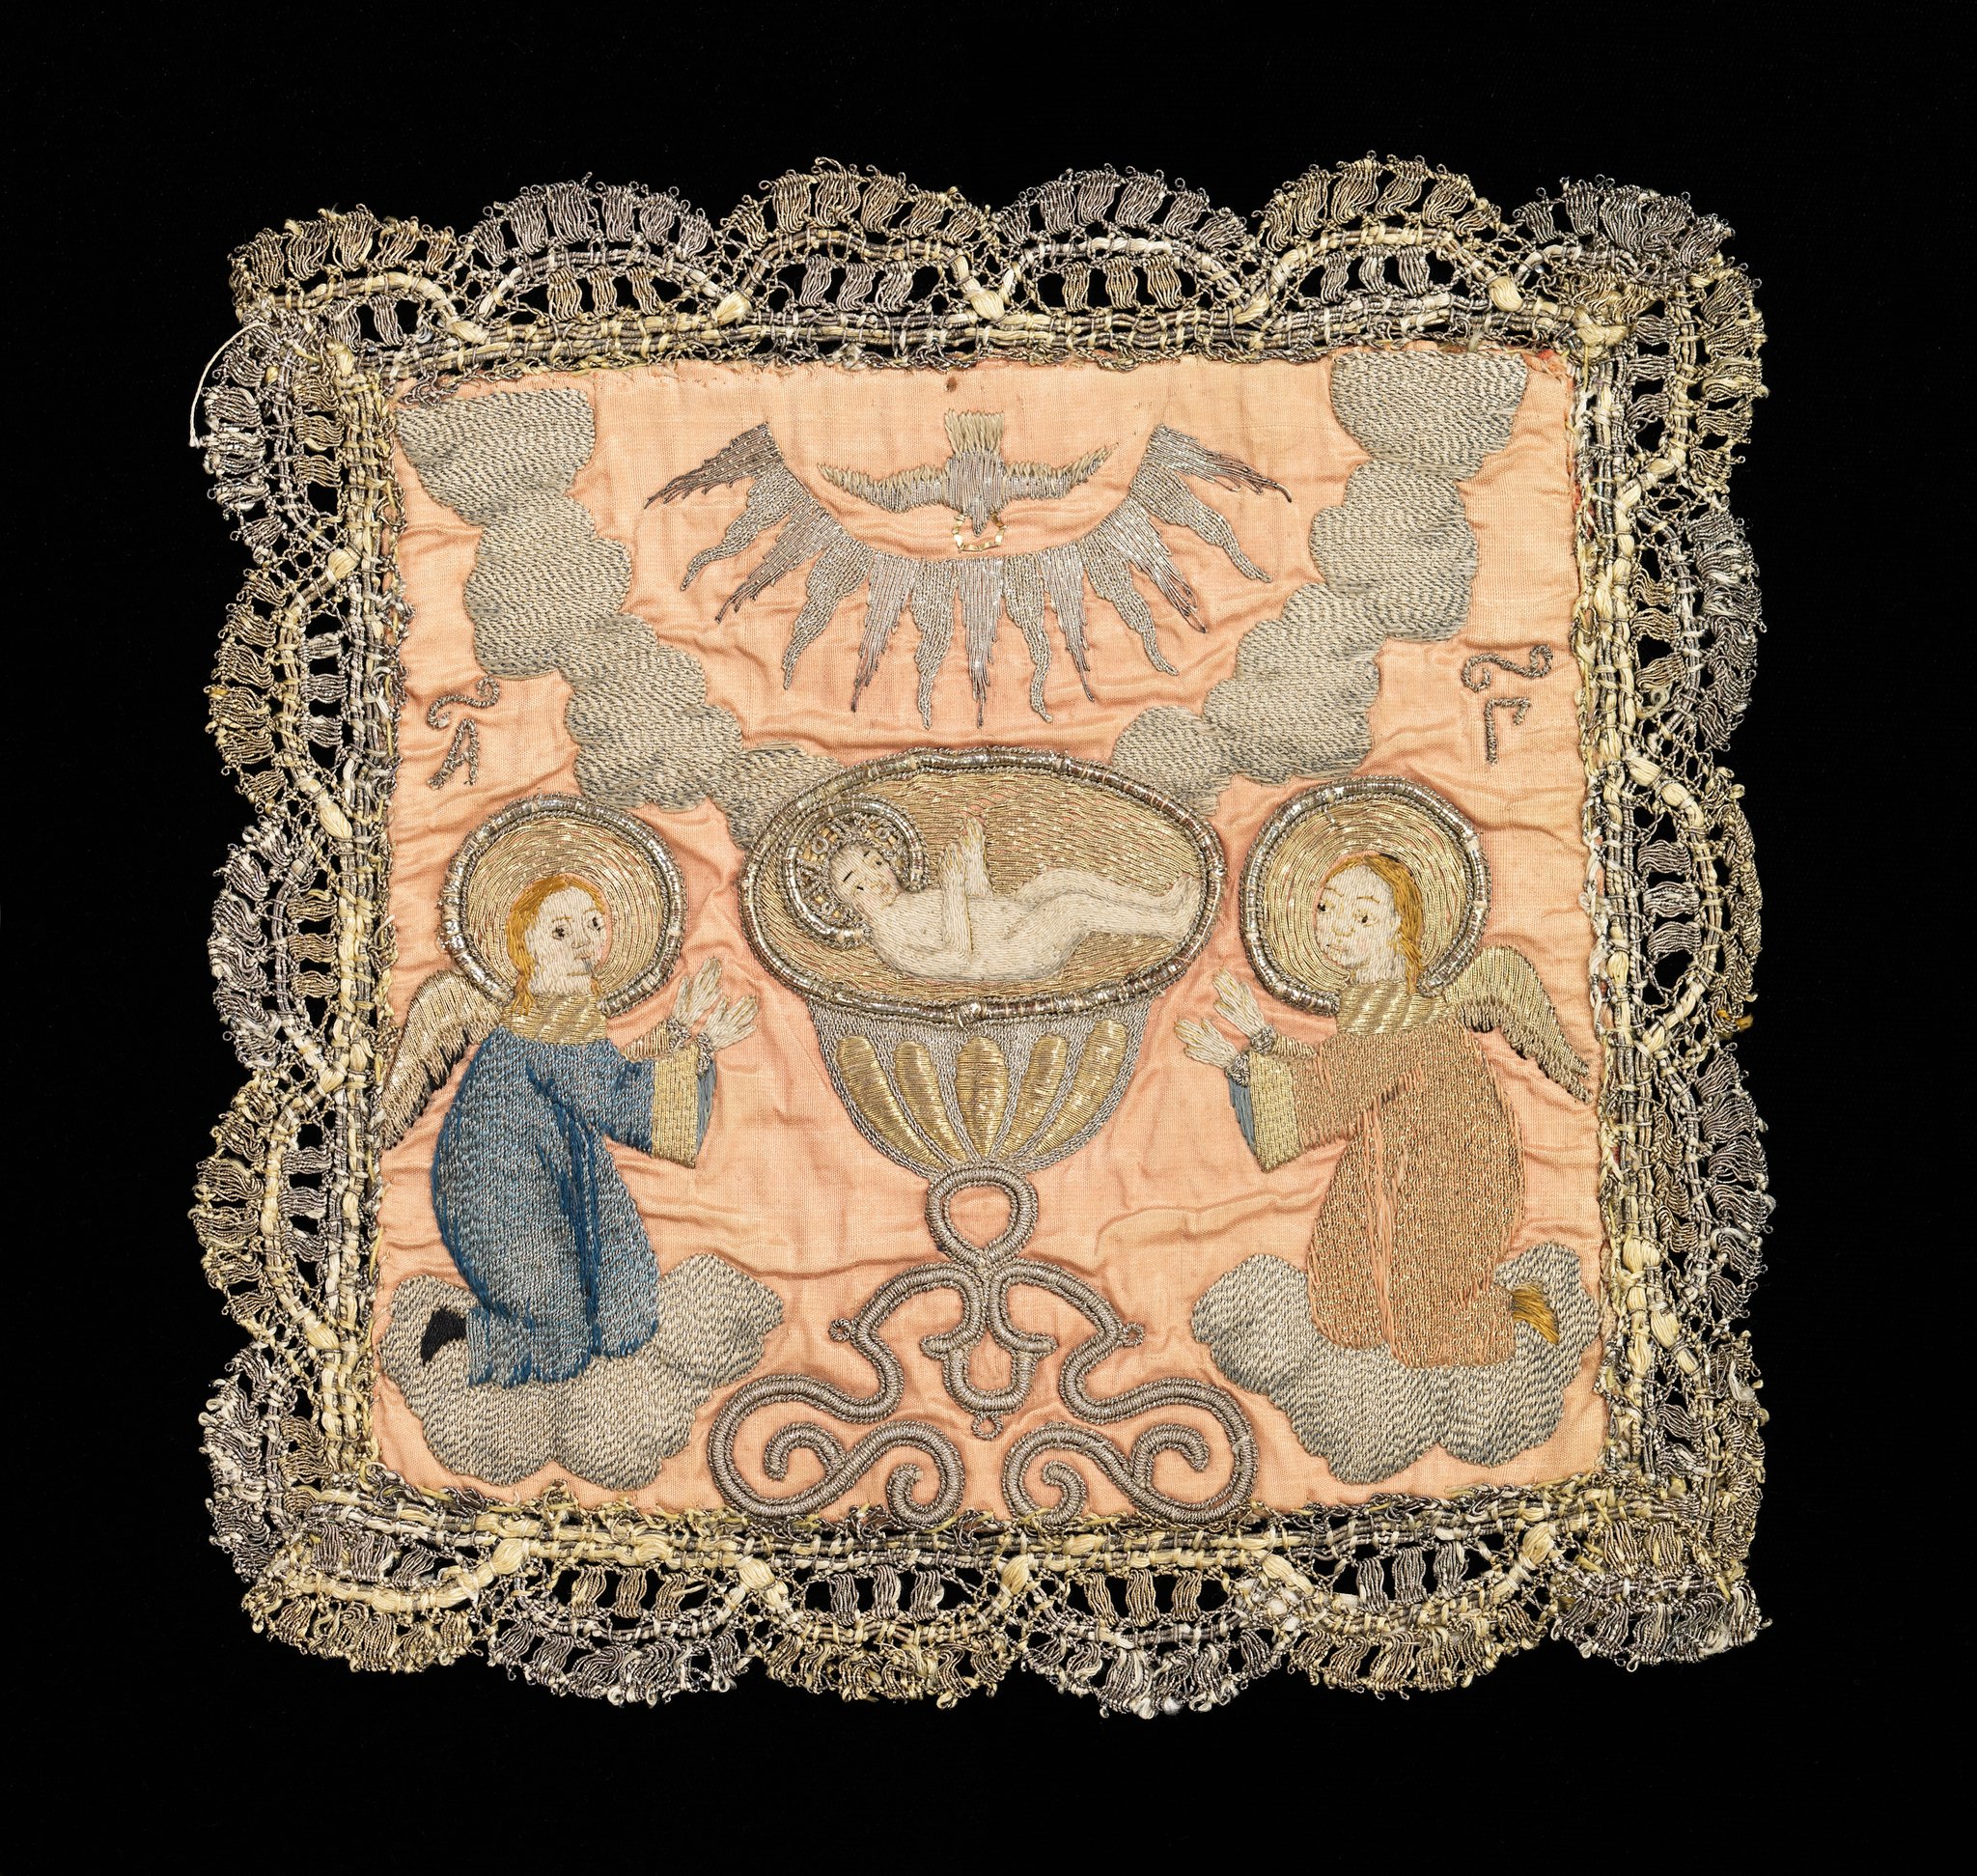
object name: paten cover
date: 1501-1600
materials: metal, silk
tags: doves,angels,jesus